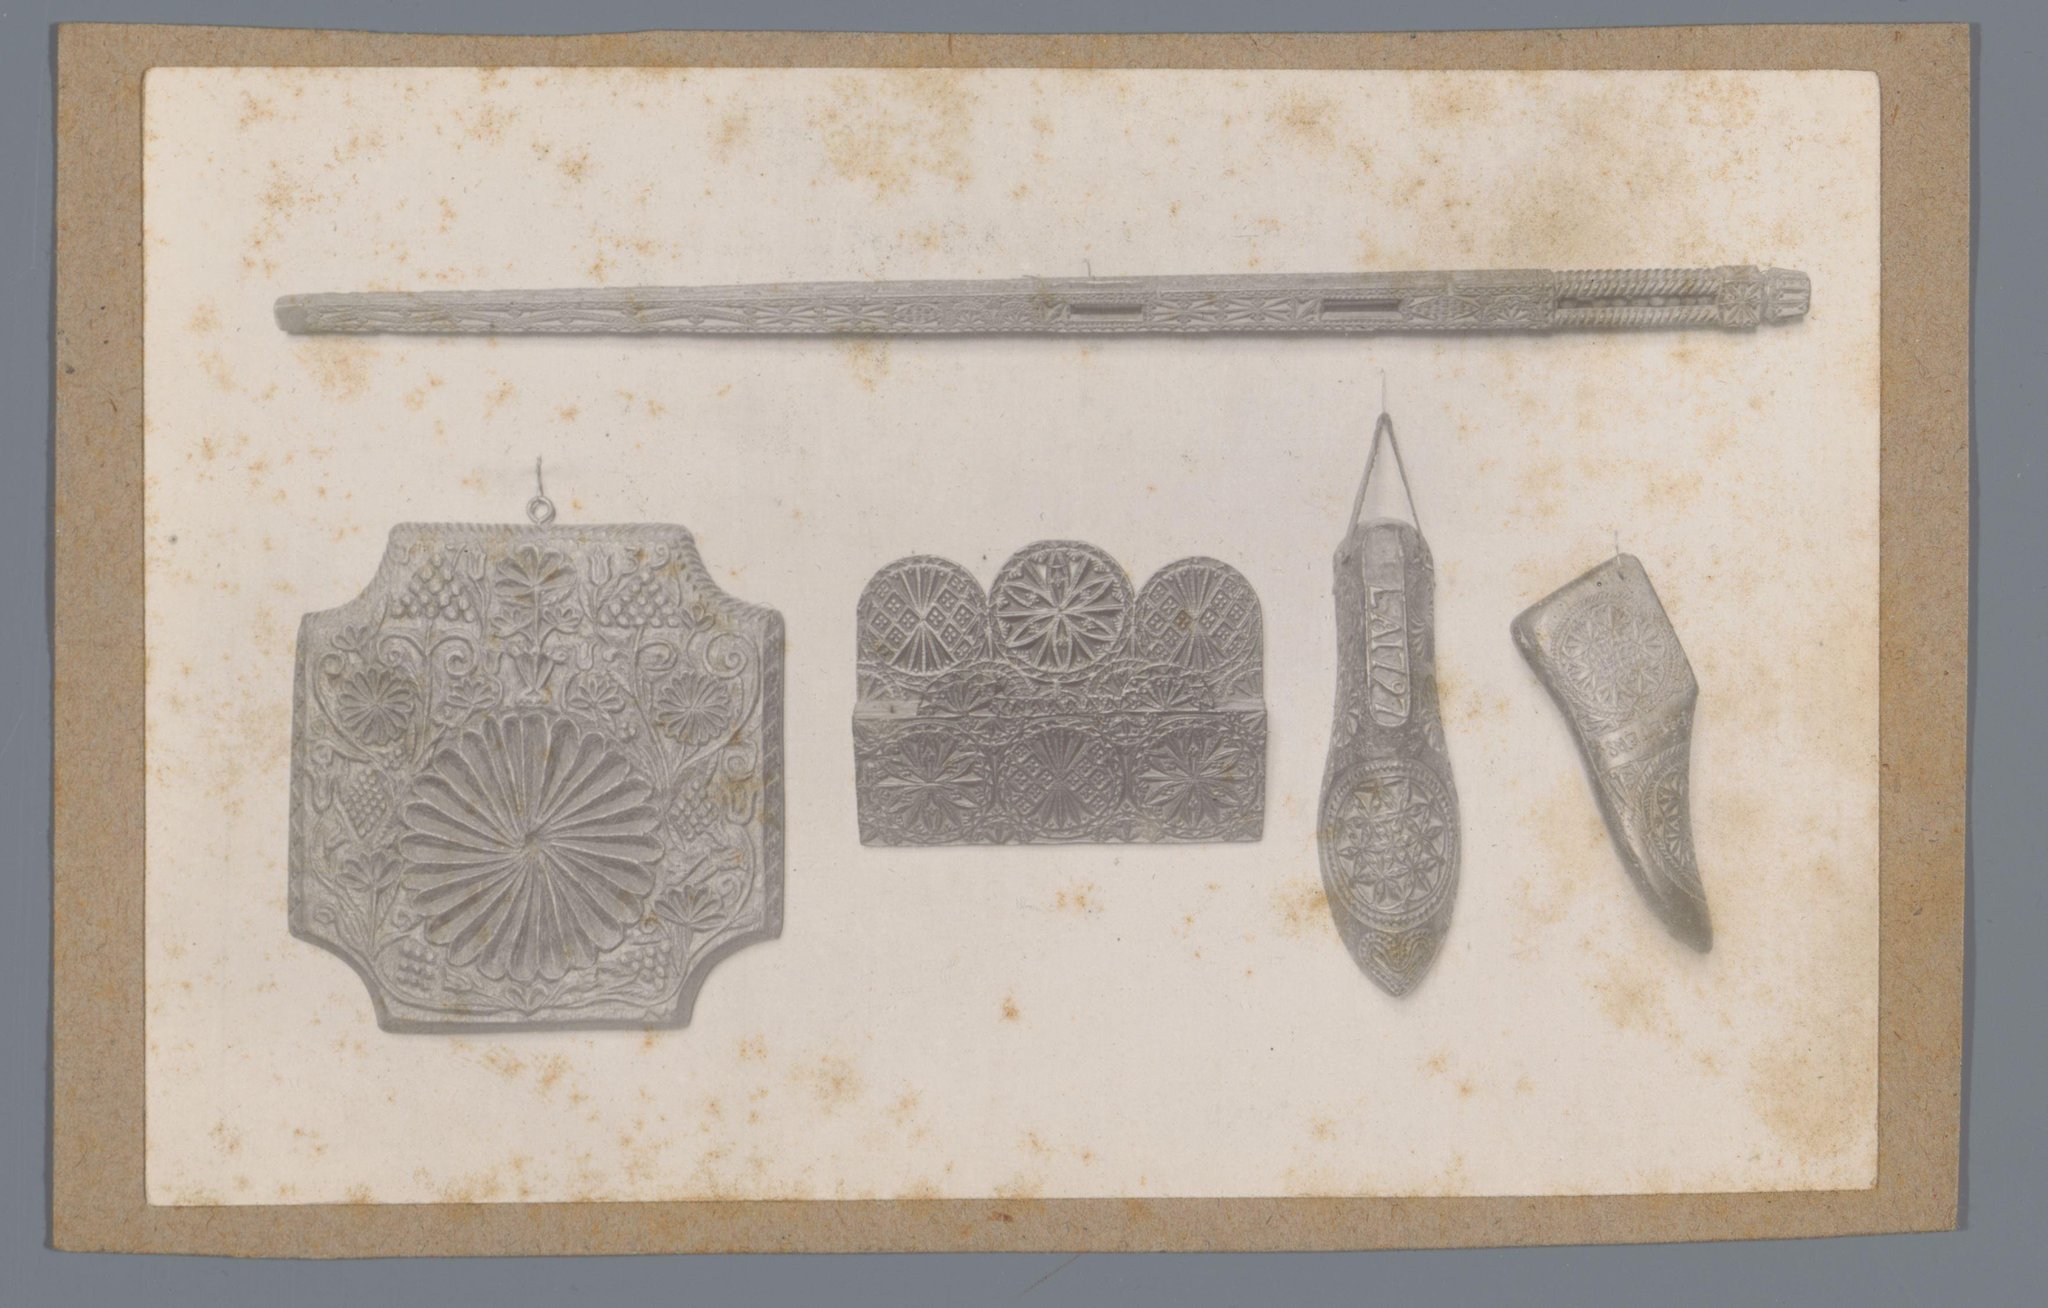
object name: photograph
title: Vijf voorwerpen gedecoreerd met bloemmotieven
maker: Anonymous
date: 1875-1900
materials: photographic support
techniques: matte daylight collodion silver print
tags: flowers ~ ornament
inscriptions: collector's mark: ‘Kunstnijverheidschool Quellinus Amsterdam Frans Halsstraat 14.’, collector's mark: ‘Instituut voor kunst-nijverheidsonderwijs Gabriël Metsustraat No. 16, Amsterdam’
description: Boven: langwerpige stok, onder: twee panelen en twee vormen die lijken op voeten.